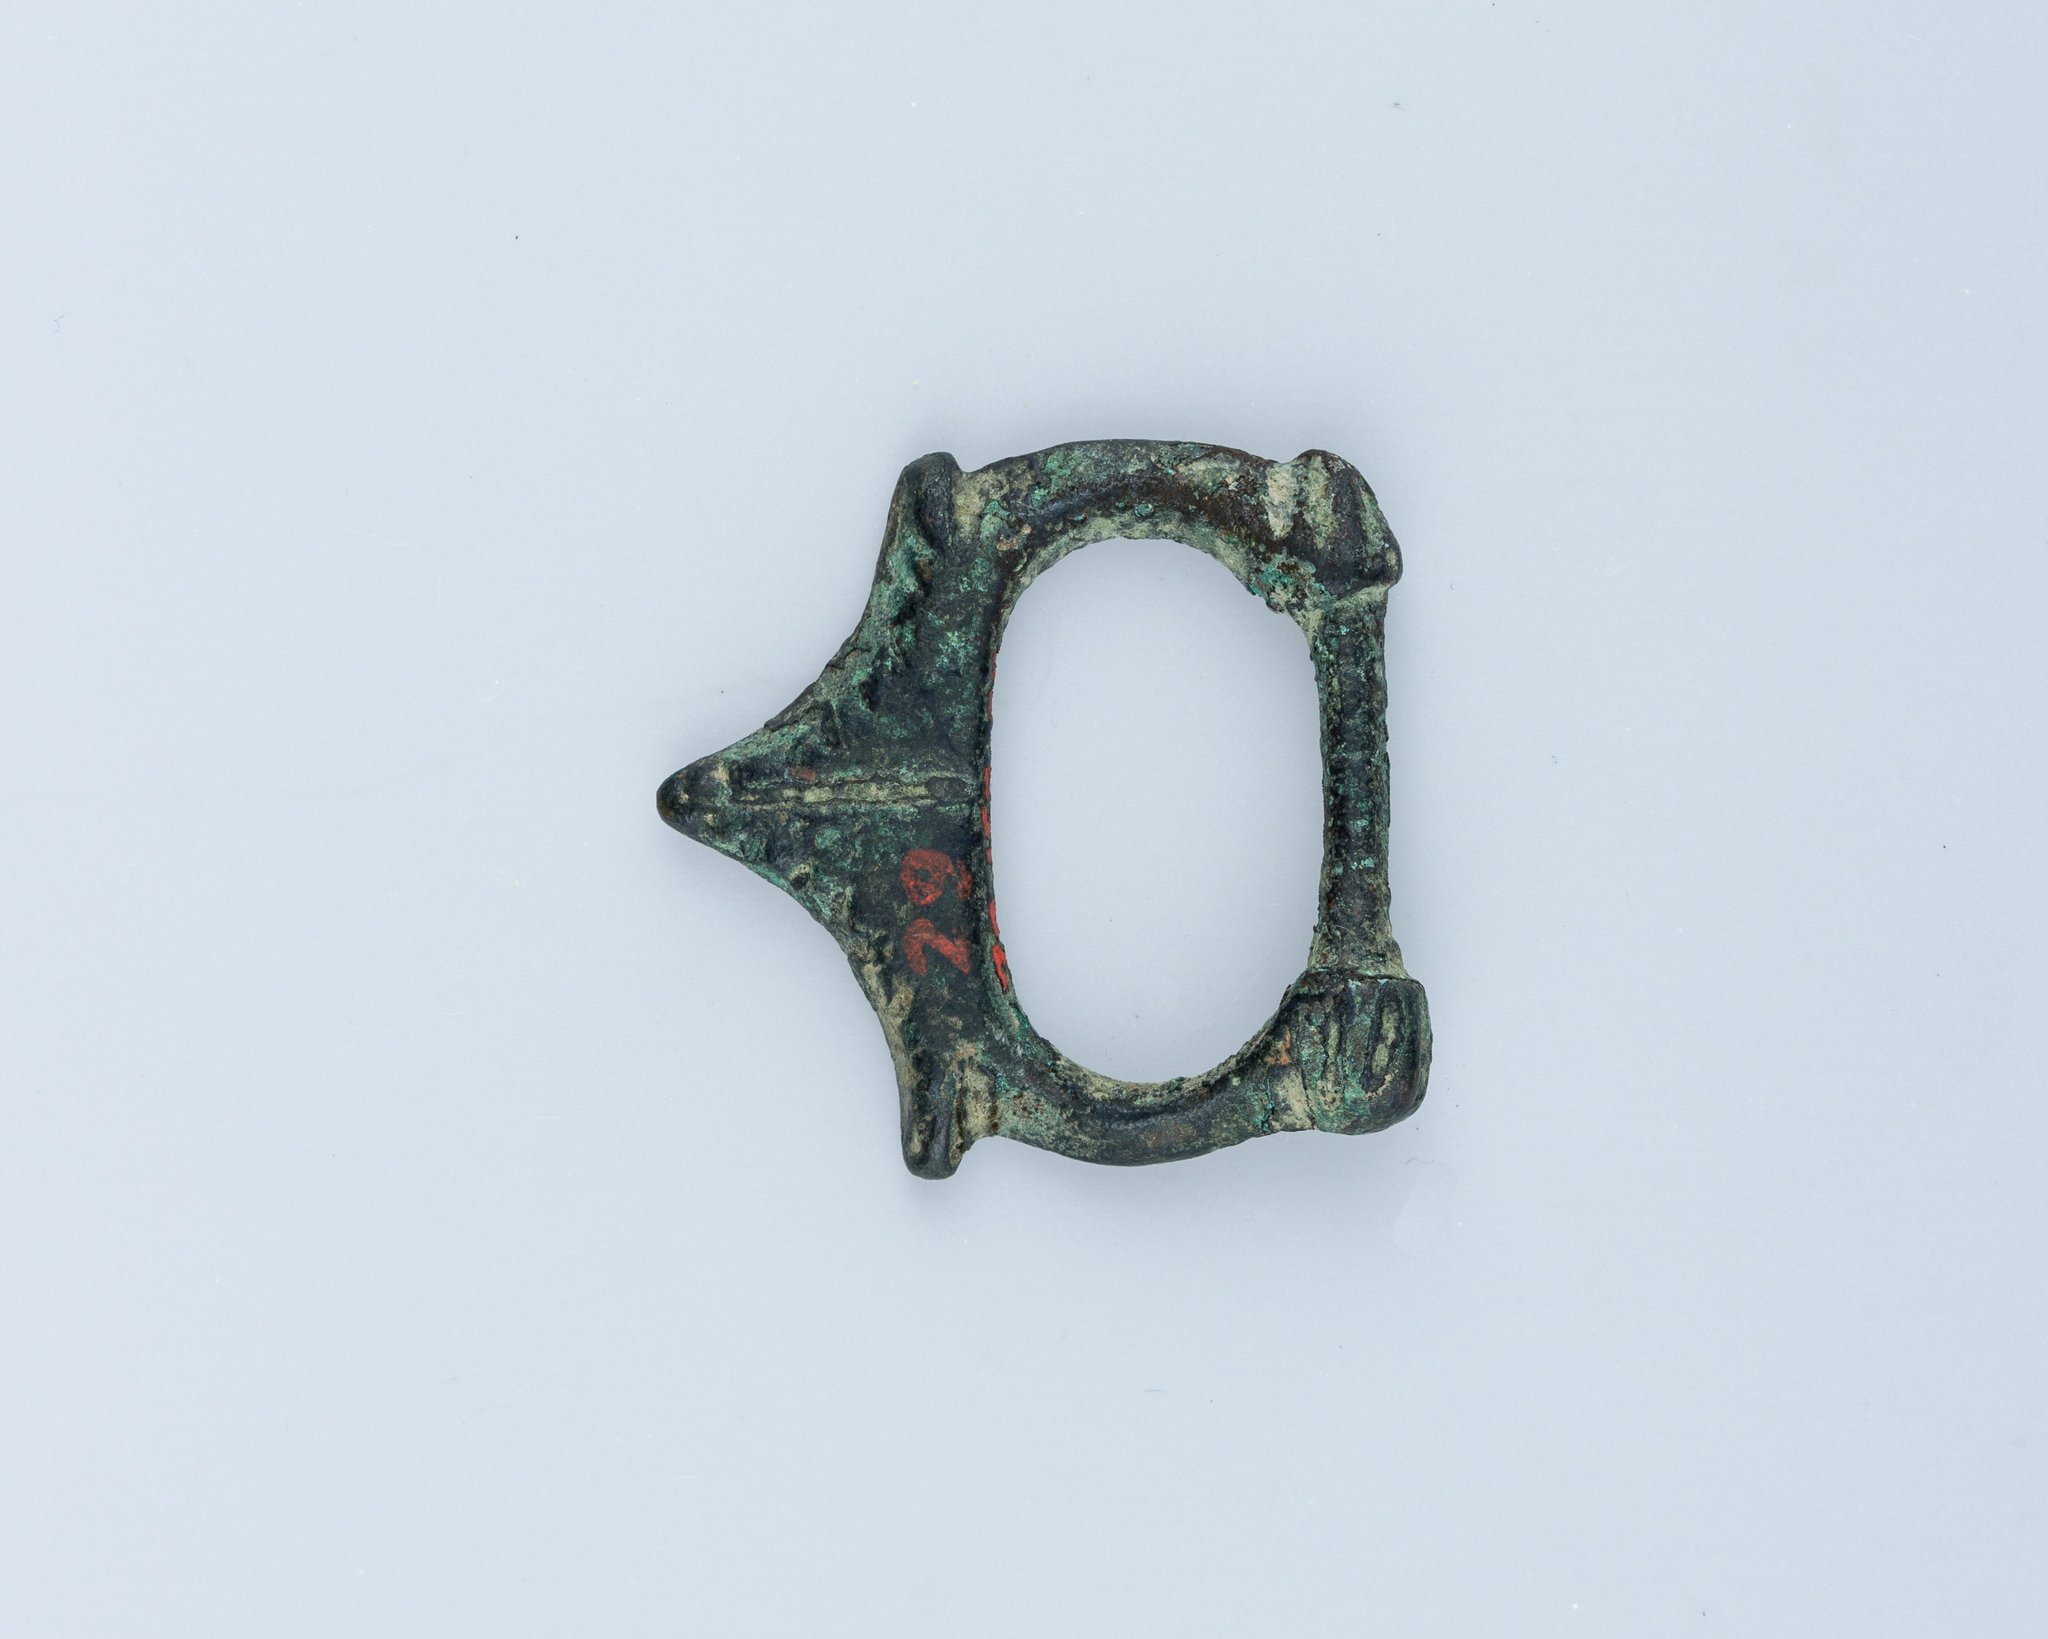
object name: buckle loop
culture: french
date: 1401-1500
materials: bronze, patina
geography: france